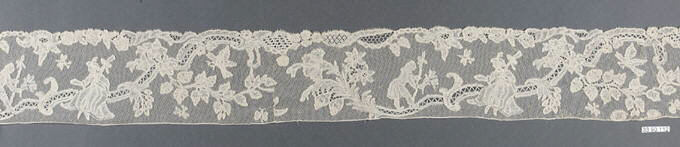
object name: edging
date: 1701-1800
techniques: lace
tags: flowers